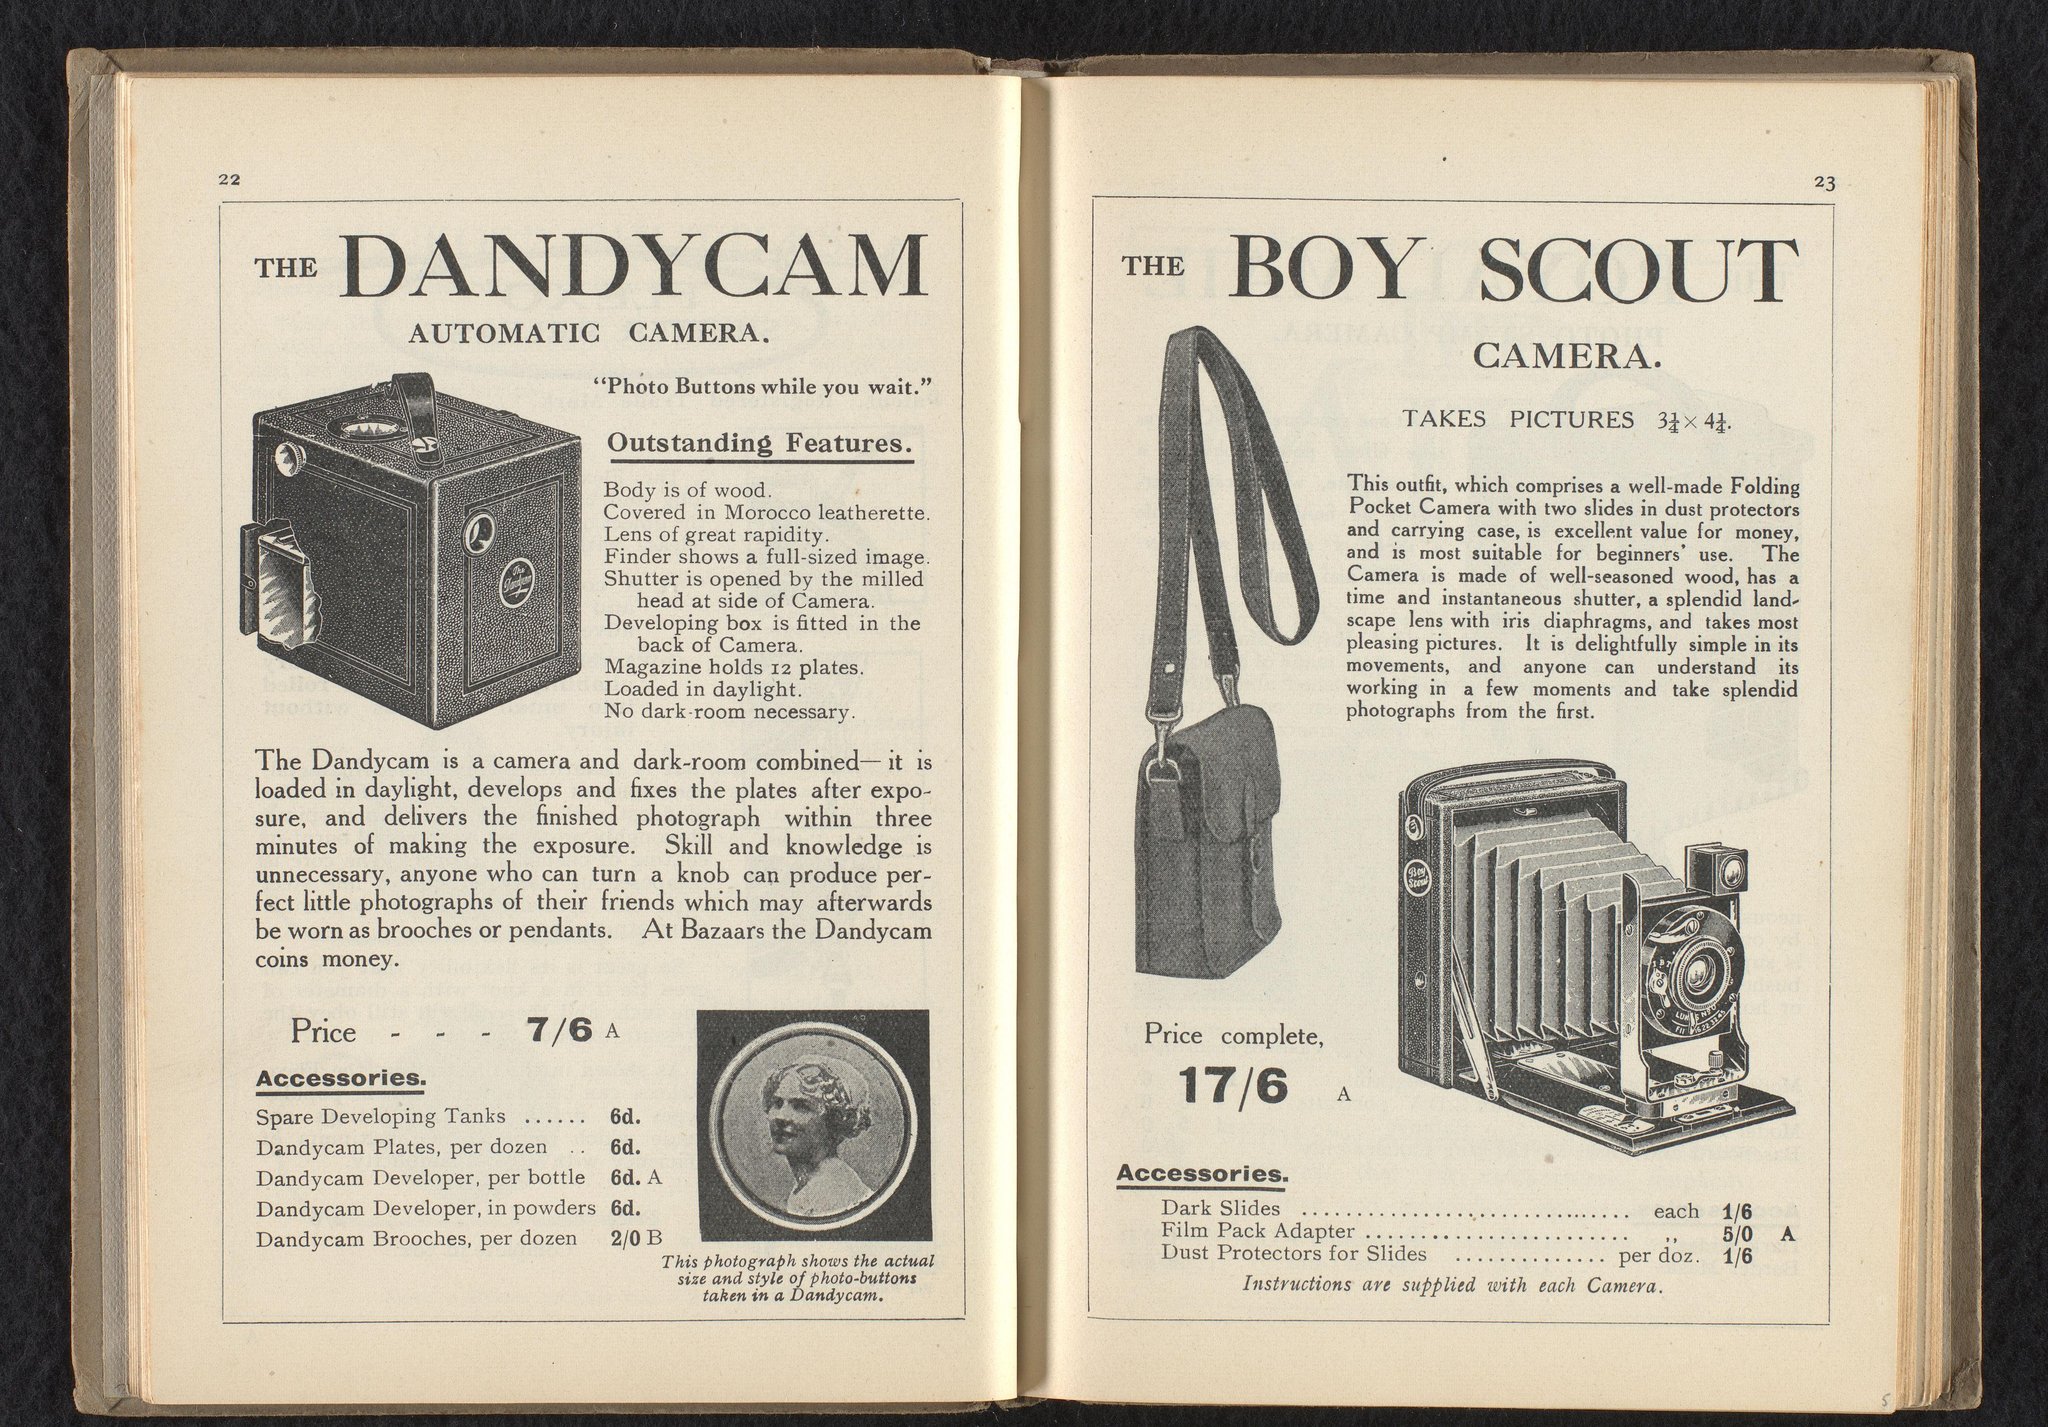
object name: page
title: Schoudertas voor de Boy Scout Camera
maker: Anonymous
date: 1907-1912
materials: paper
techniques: letterpress printing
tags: container of leather: leather bag